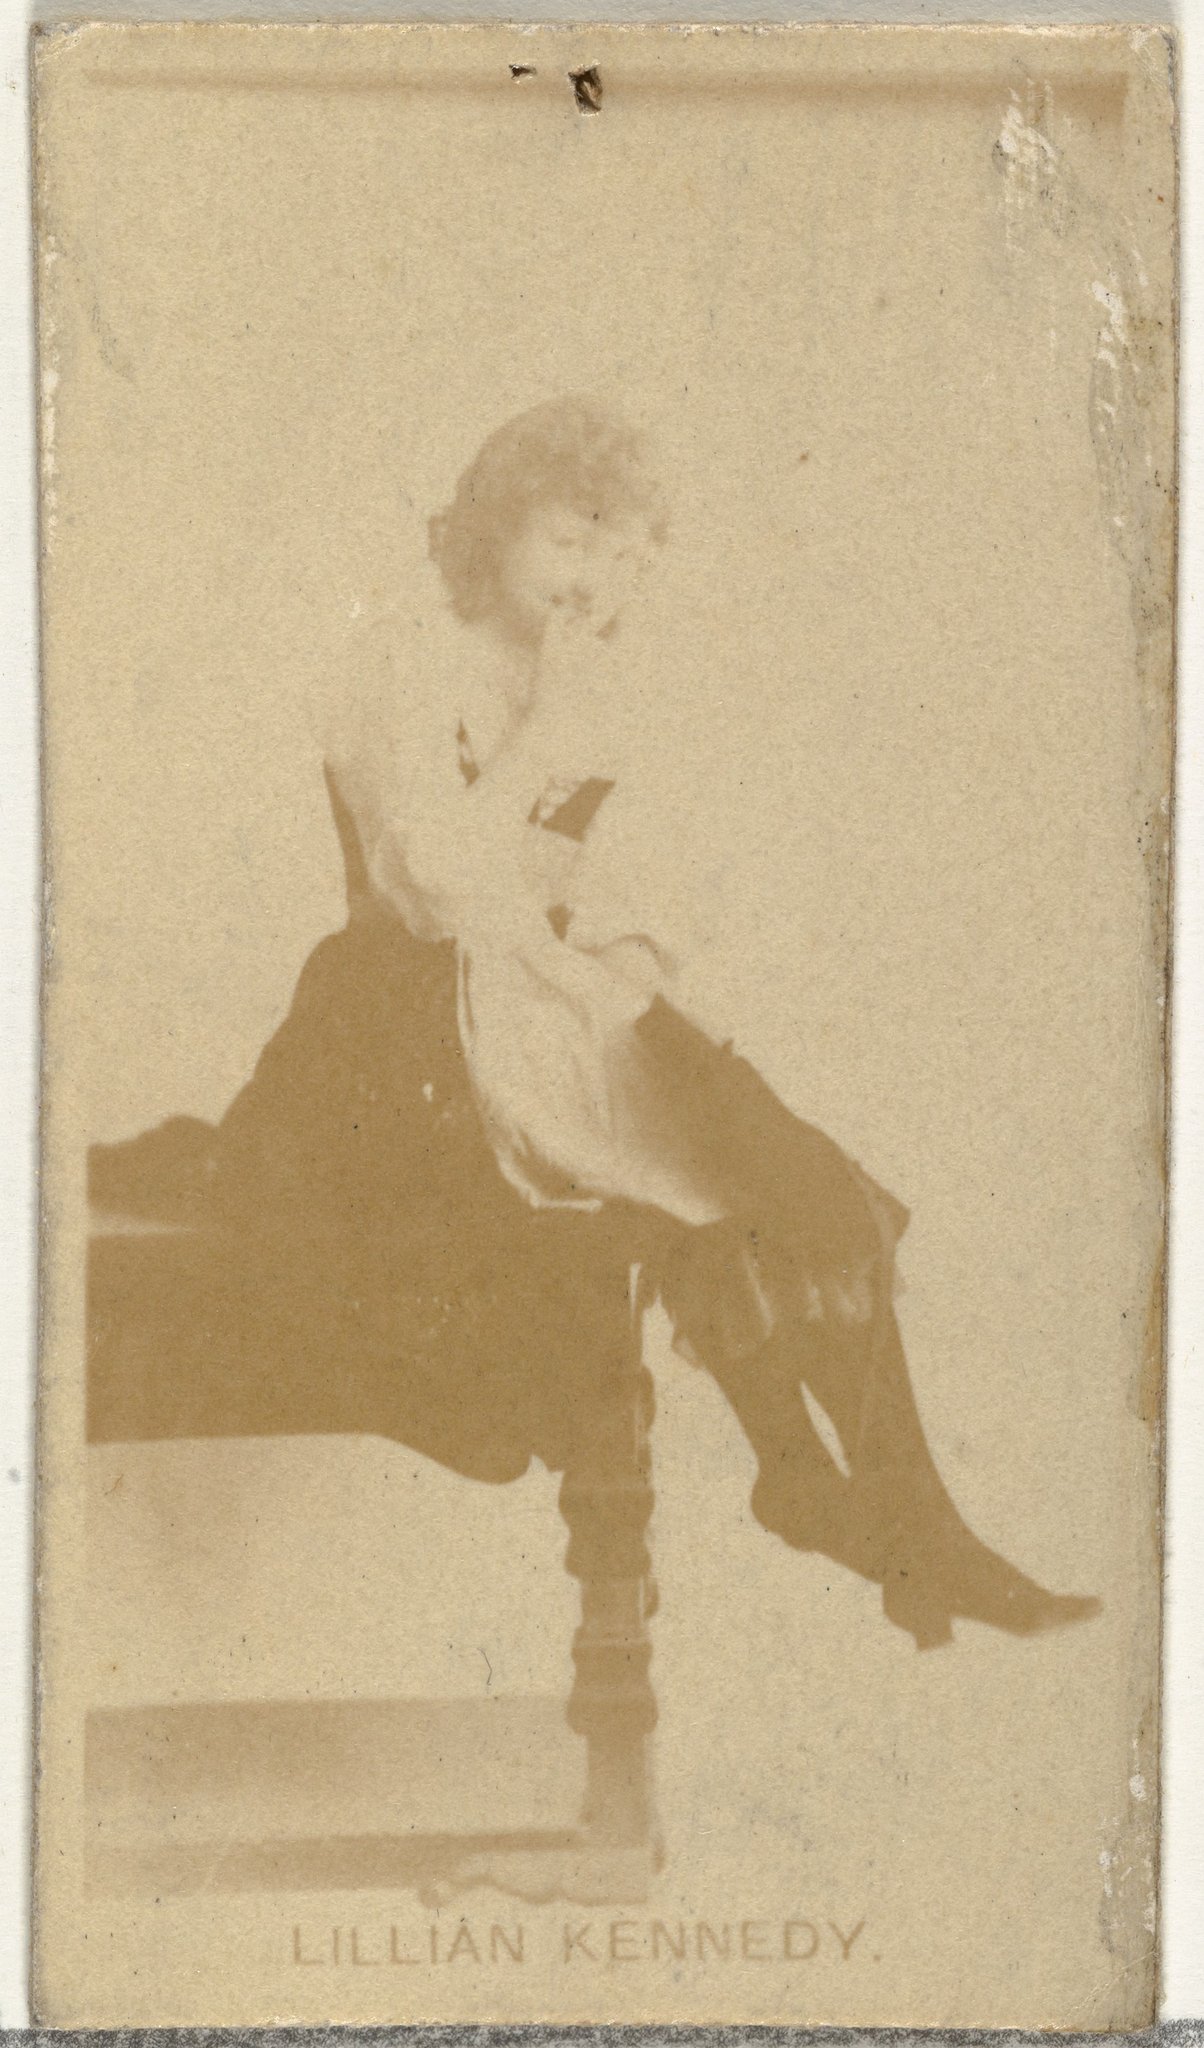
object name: photograph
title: Lillian Kennedy, from the Actors and Actresses series (N145-8) issued by Duke Sons & Co. to promote Duke Cigarettes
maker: w. duke, sons & co.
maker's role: publisher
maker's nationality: american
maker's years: 1870-1920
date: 1891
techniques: albumen silver print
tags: portraits,women,actresses